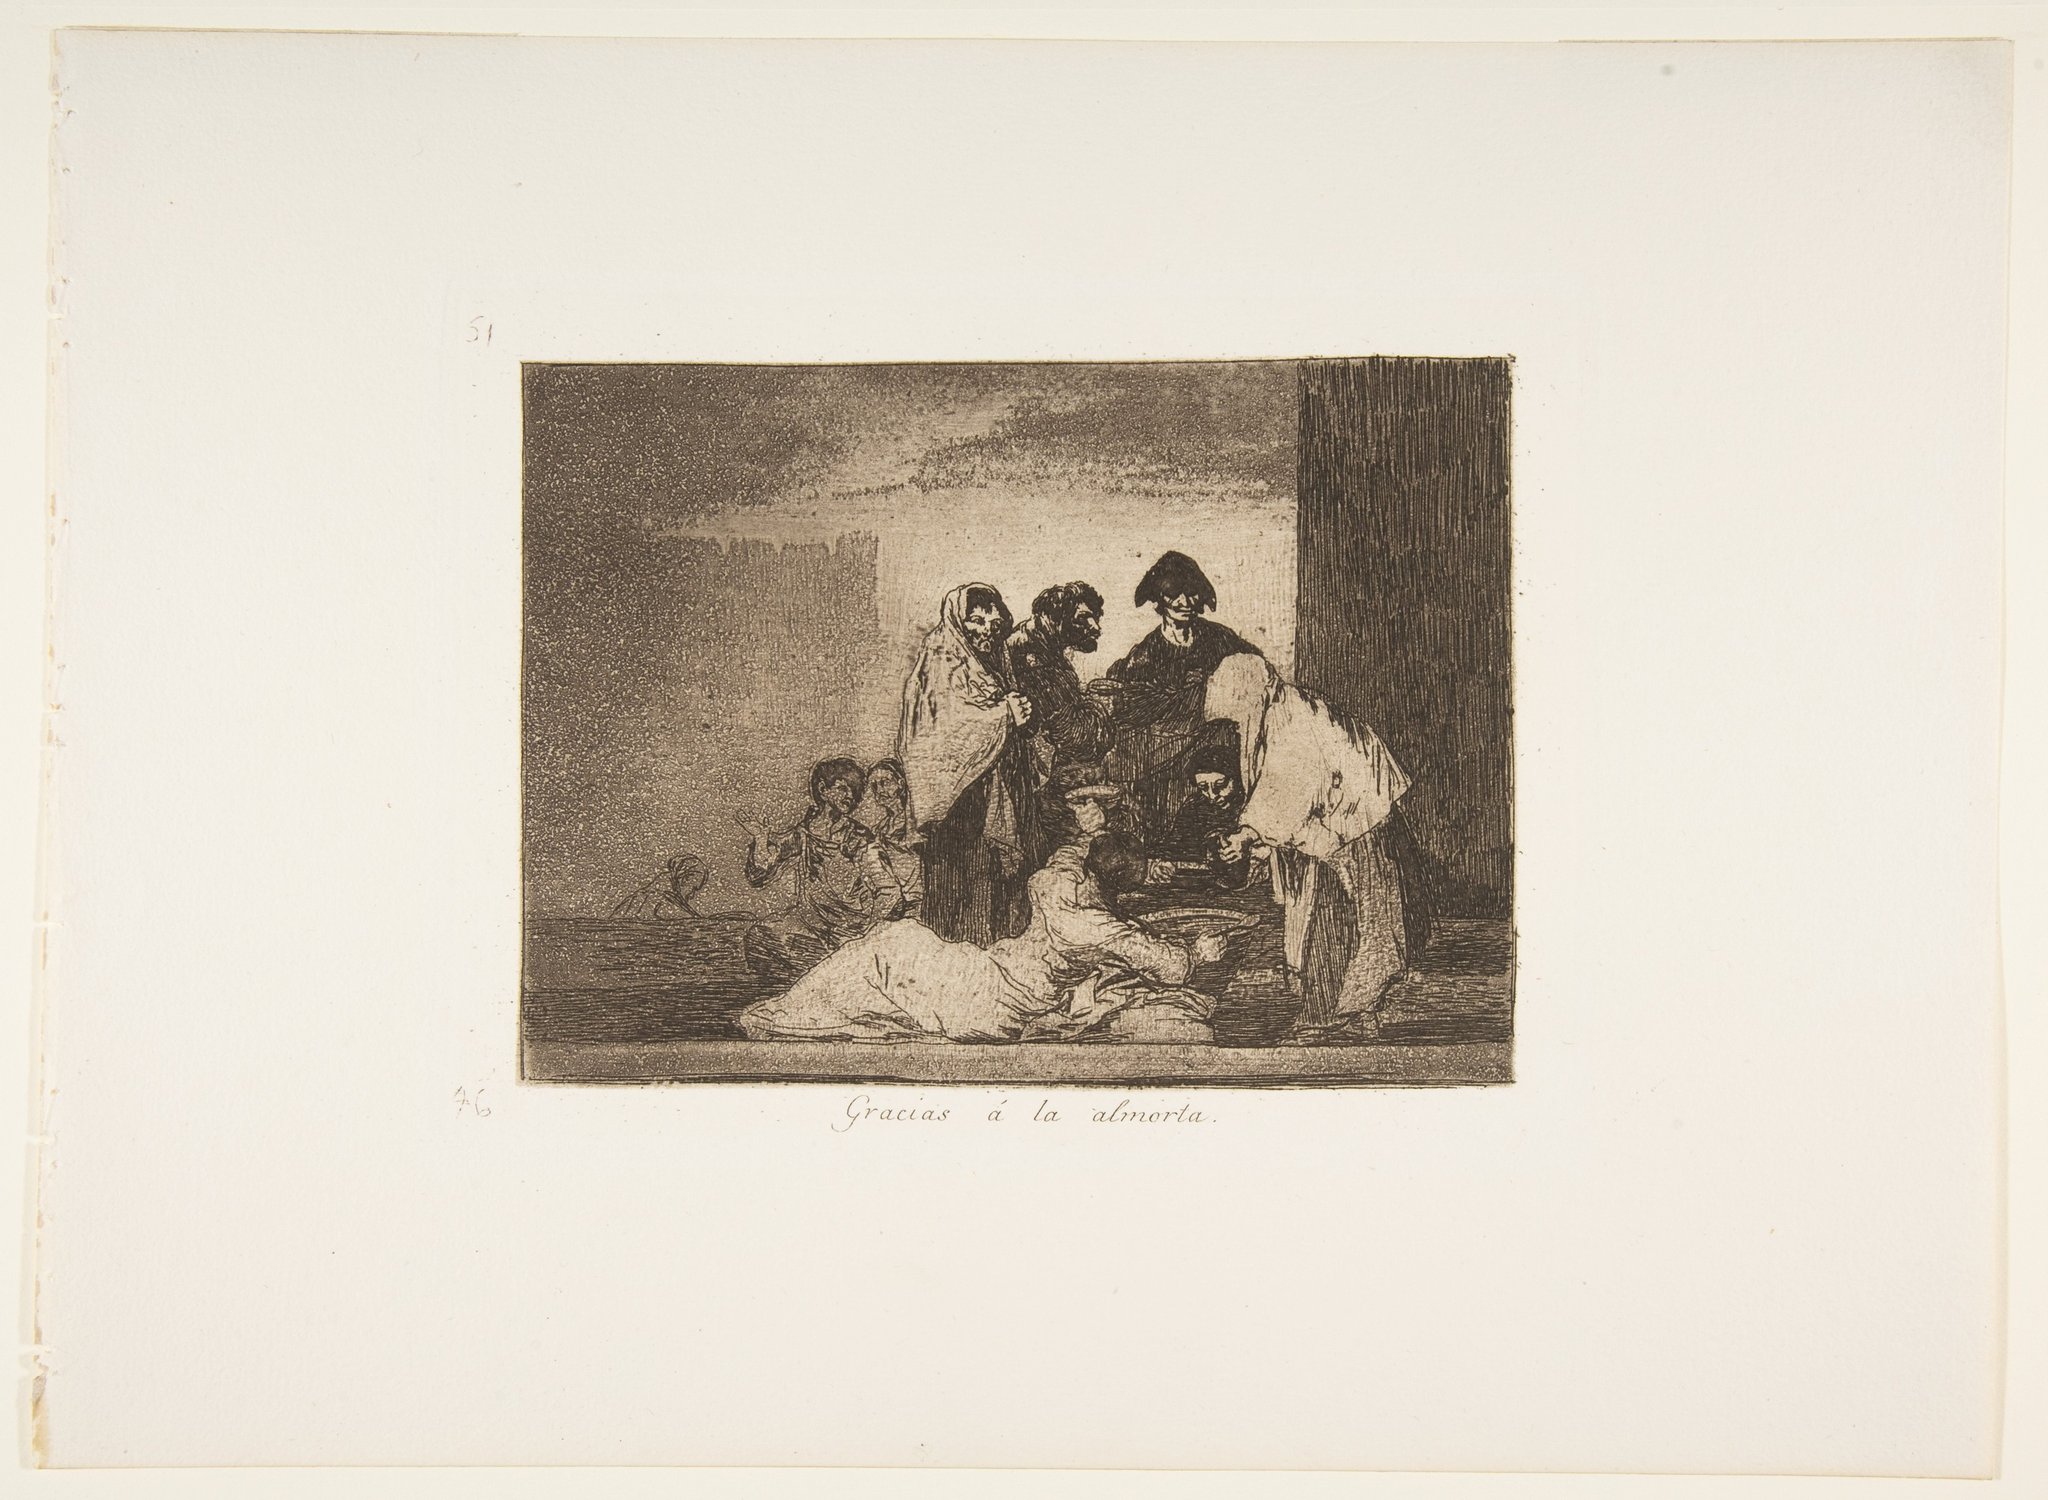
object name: print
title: Plate 51 from "The Disasters of War" (Los Desastres de la Guerra): 'Thanks to the millet' (Gracias á la almorta)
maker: goya (francisco de goya y lucientes)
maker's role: artist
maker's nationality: spanish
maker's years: 1746-1828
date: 1811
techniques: aquatint, burnishing, etching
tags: men,women